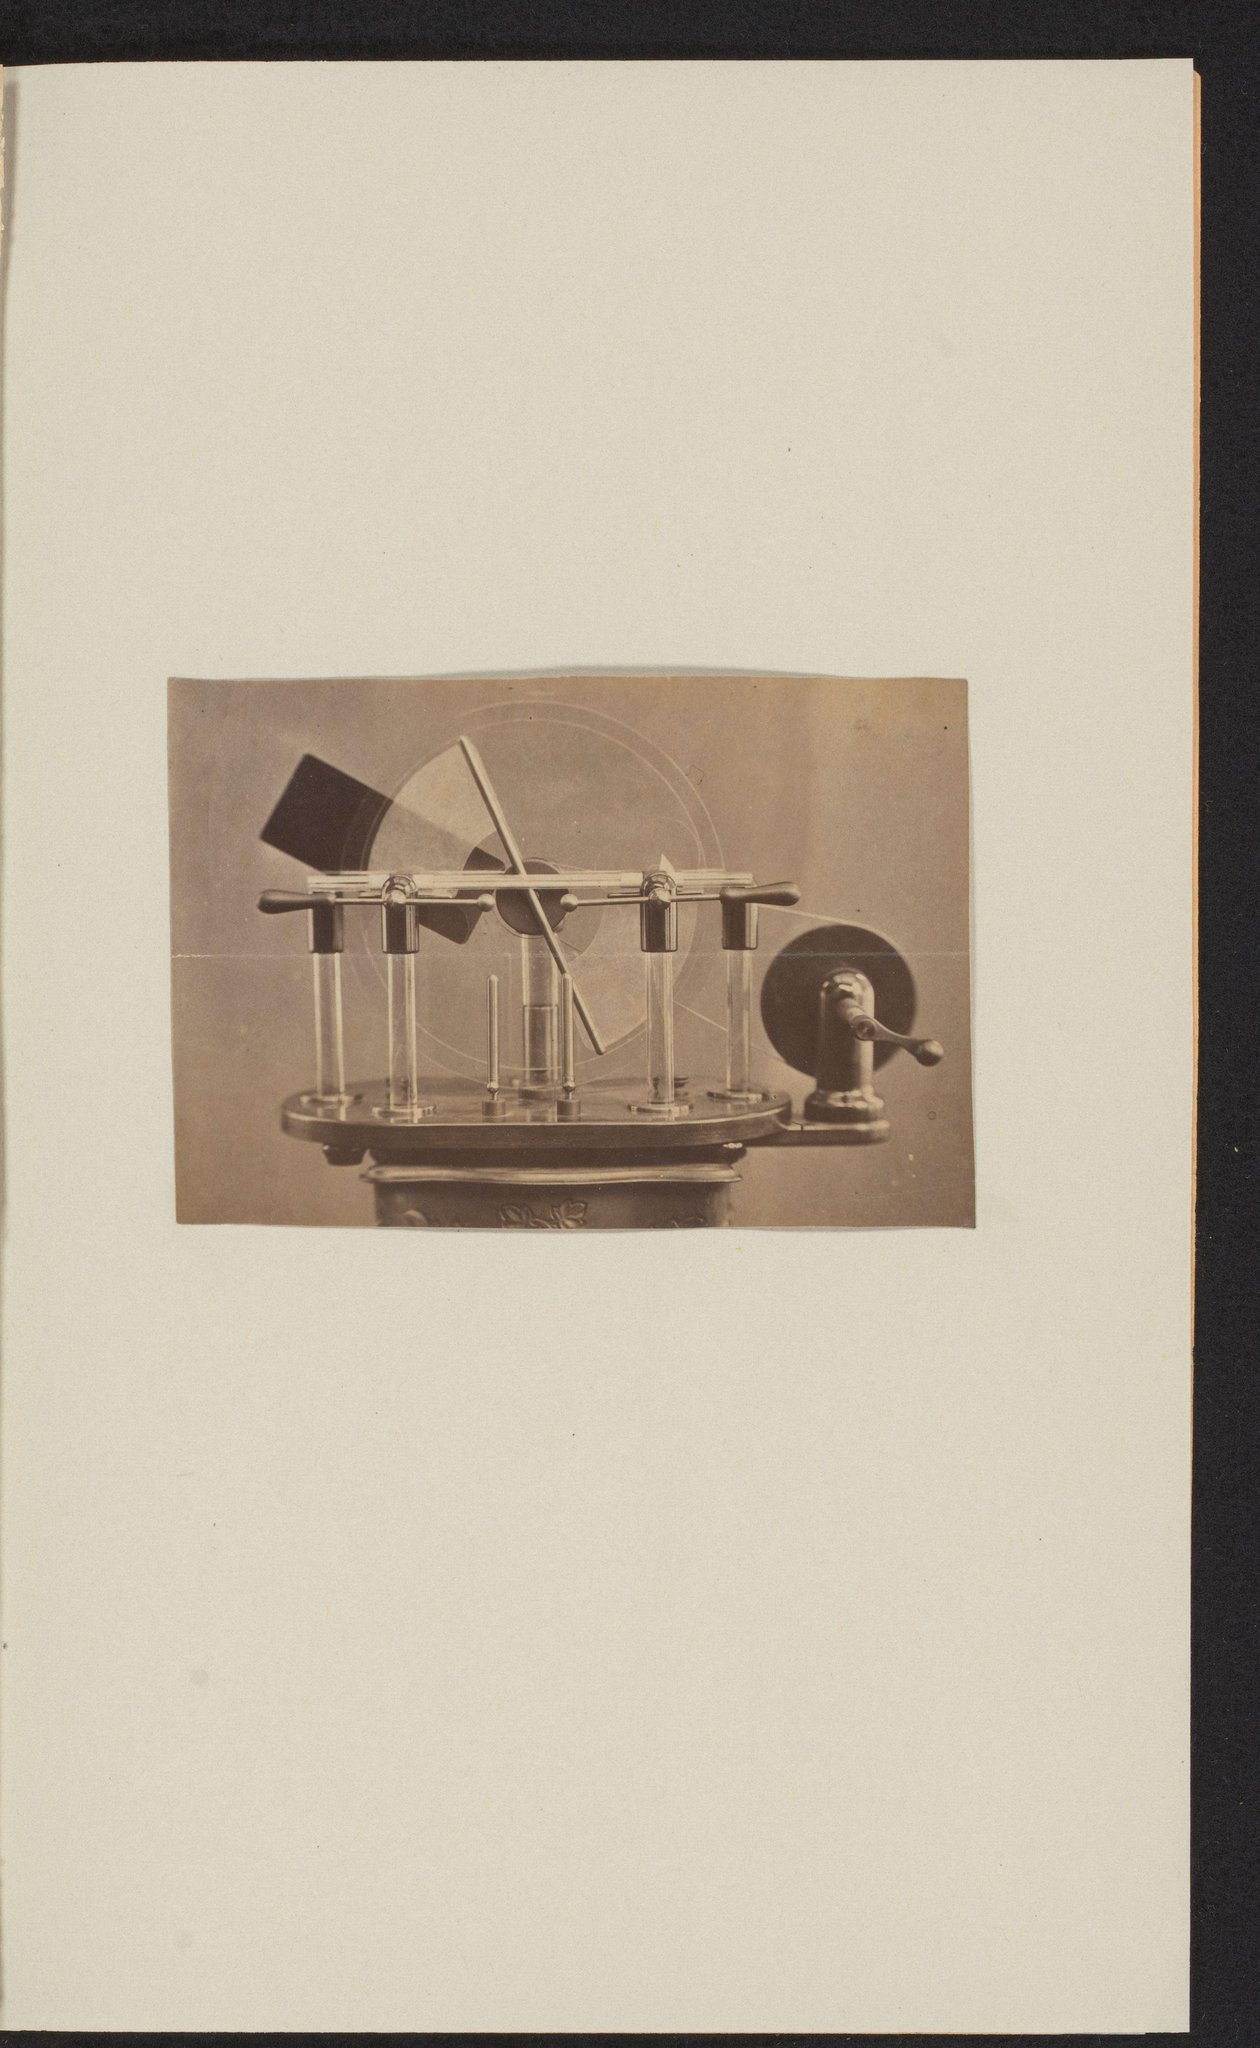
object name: page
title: Natuurkundig instrument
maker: fredrich wilhelm funckler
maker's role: instrument maker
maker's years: 1836-1886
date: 1857-1867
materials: photographic support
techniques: albumen print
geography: netherlands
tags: physics (+ tools, instruments; laboratory equipment ~ scientific research)